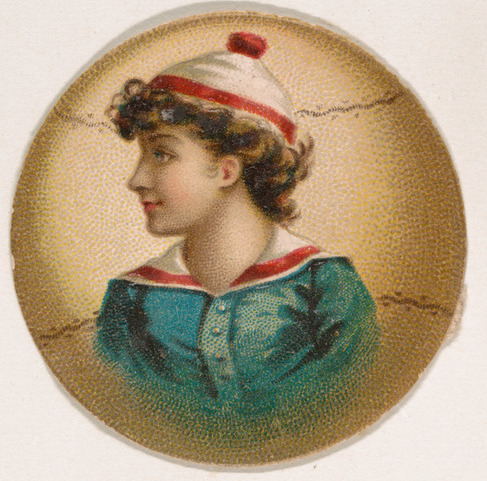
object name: print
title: Baseball, from the Novelties series (N228, Type 4) issued by Kinney Bros.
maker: kinney brothers tobacco company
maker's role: publisher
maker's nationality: american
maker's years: 1869-2011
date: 1889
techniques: color lithograph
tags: girls,profiles,baseball